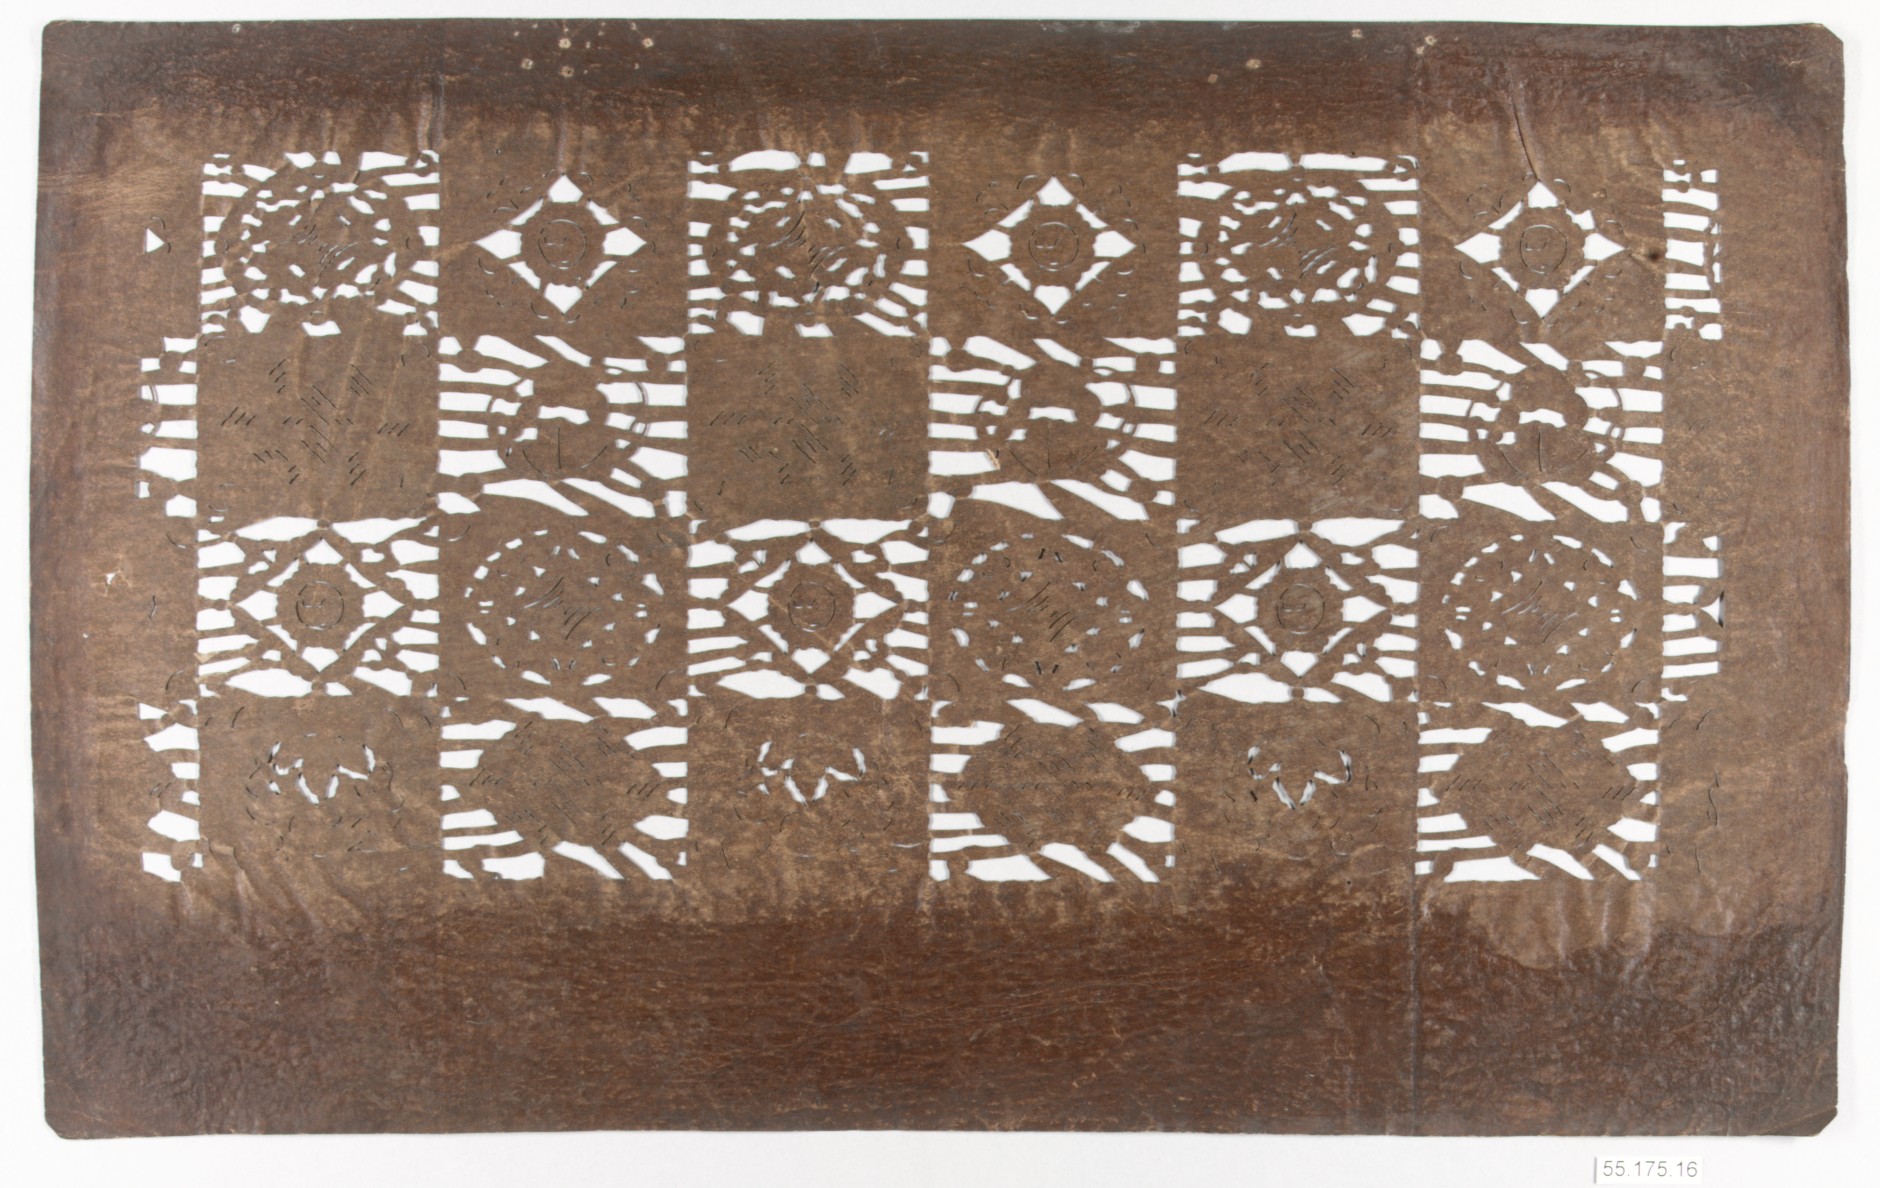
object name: stencil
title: Stencil with Pattern of Filled Squares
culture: japanese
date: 1801-1900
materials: paper